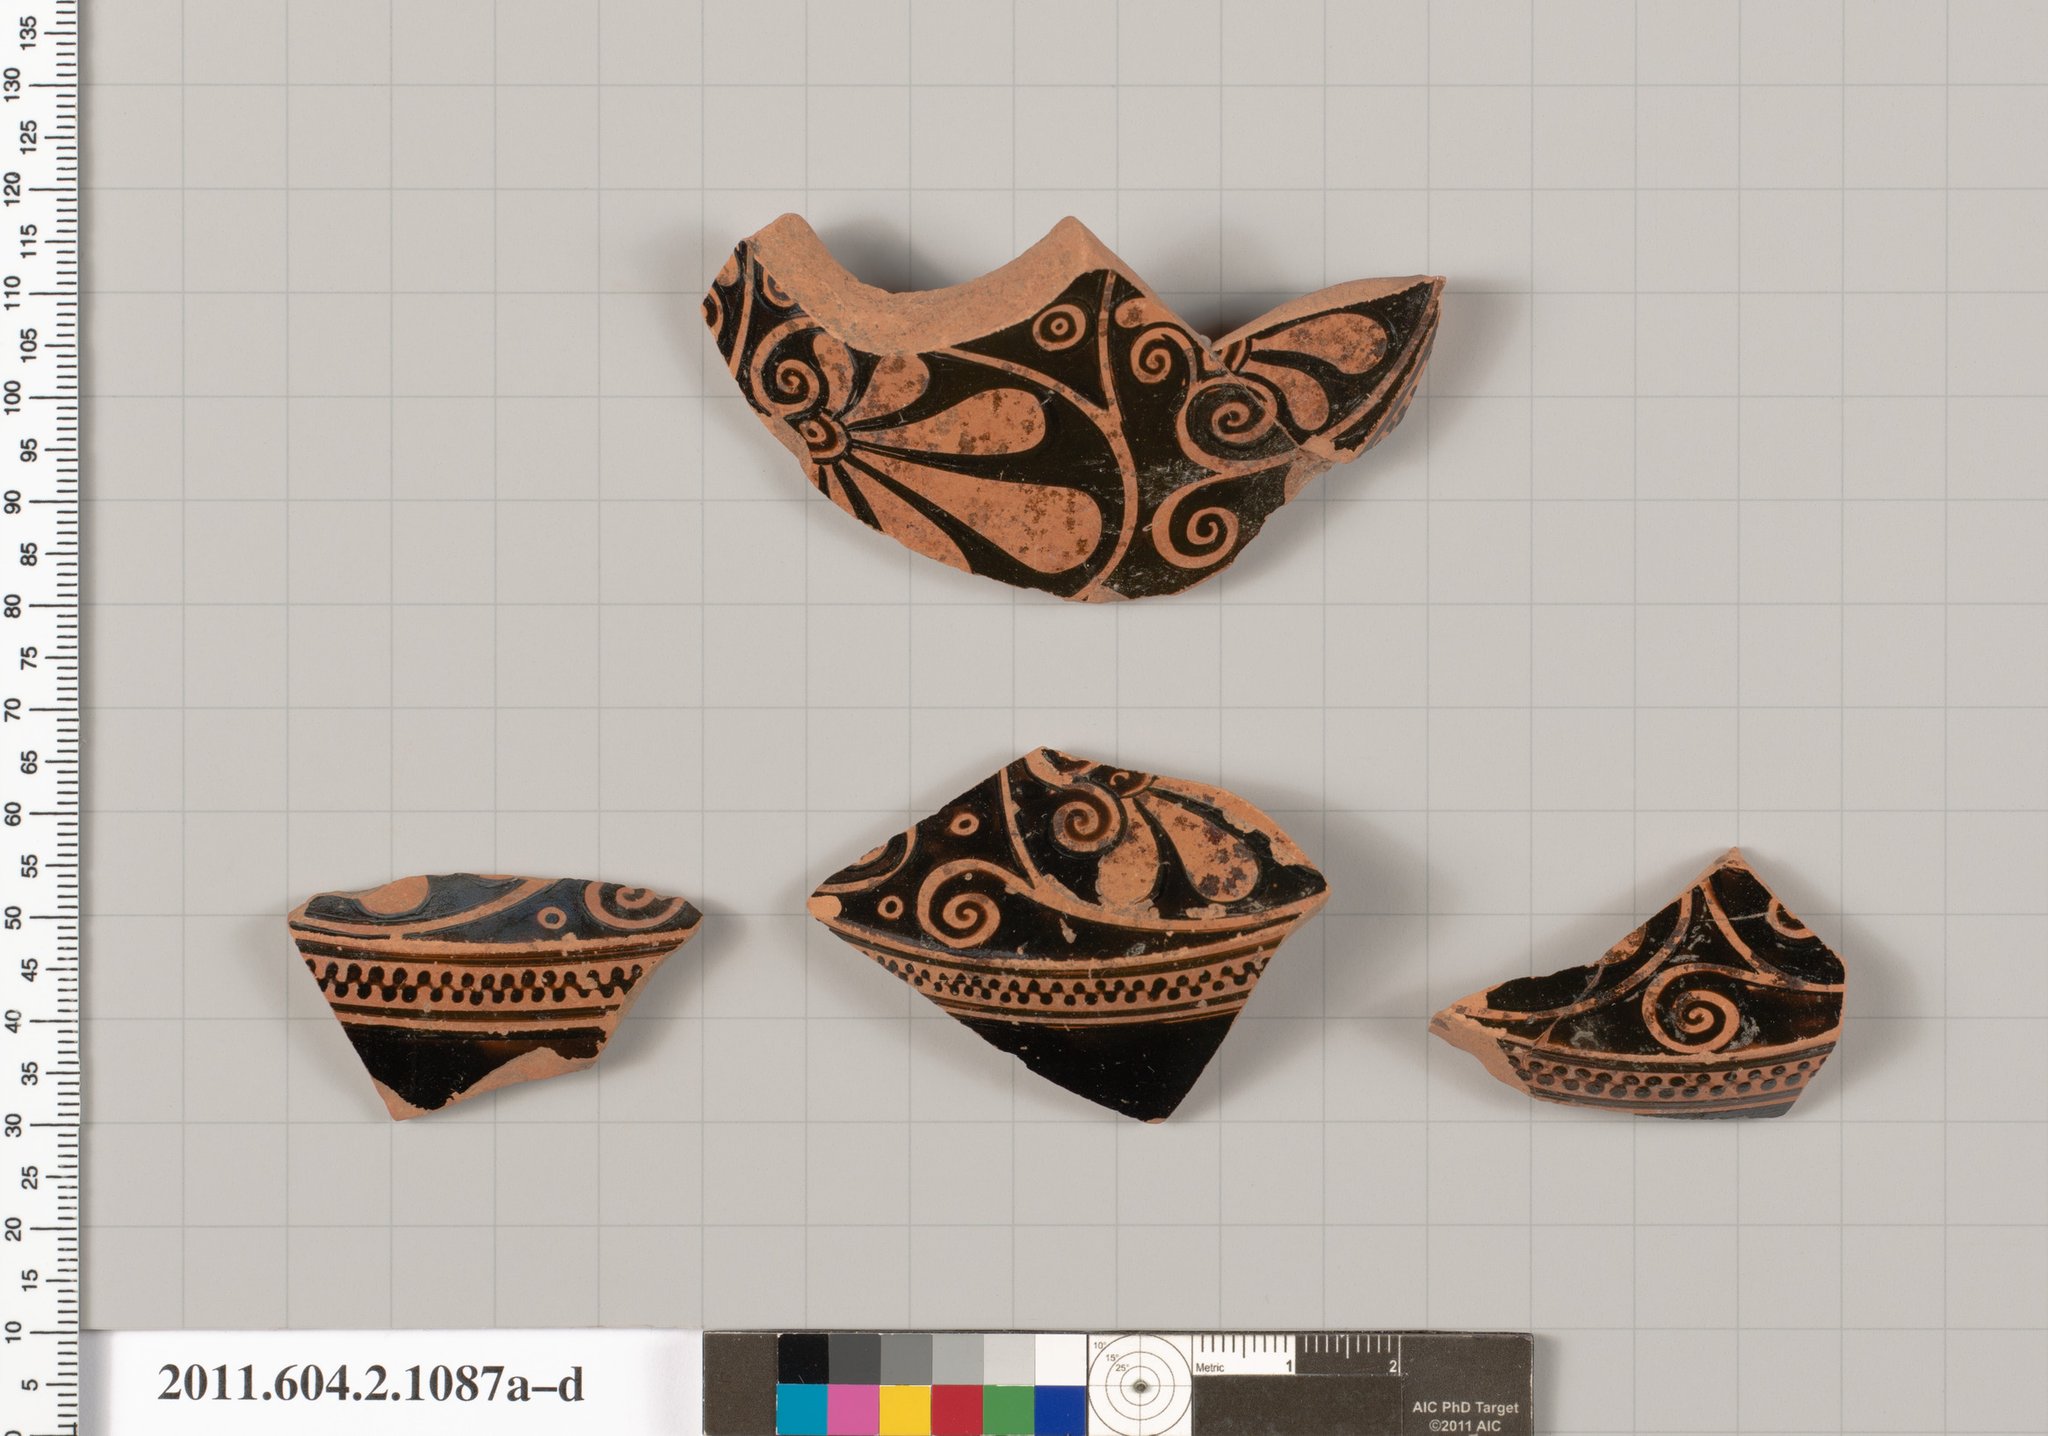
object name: lekythos fragment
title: Terracotta fragments of a lekythos (oil flask)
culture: greek, attic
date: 500-480 BCE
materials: terracotta